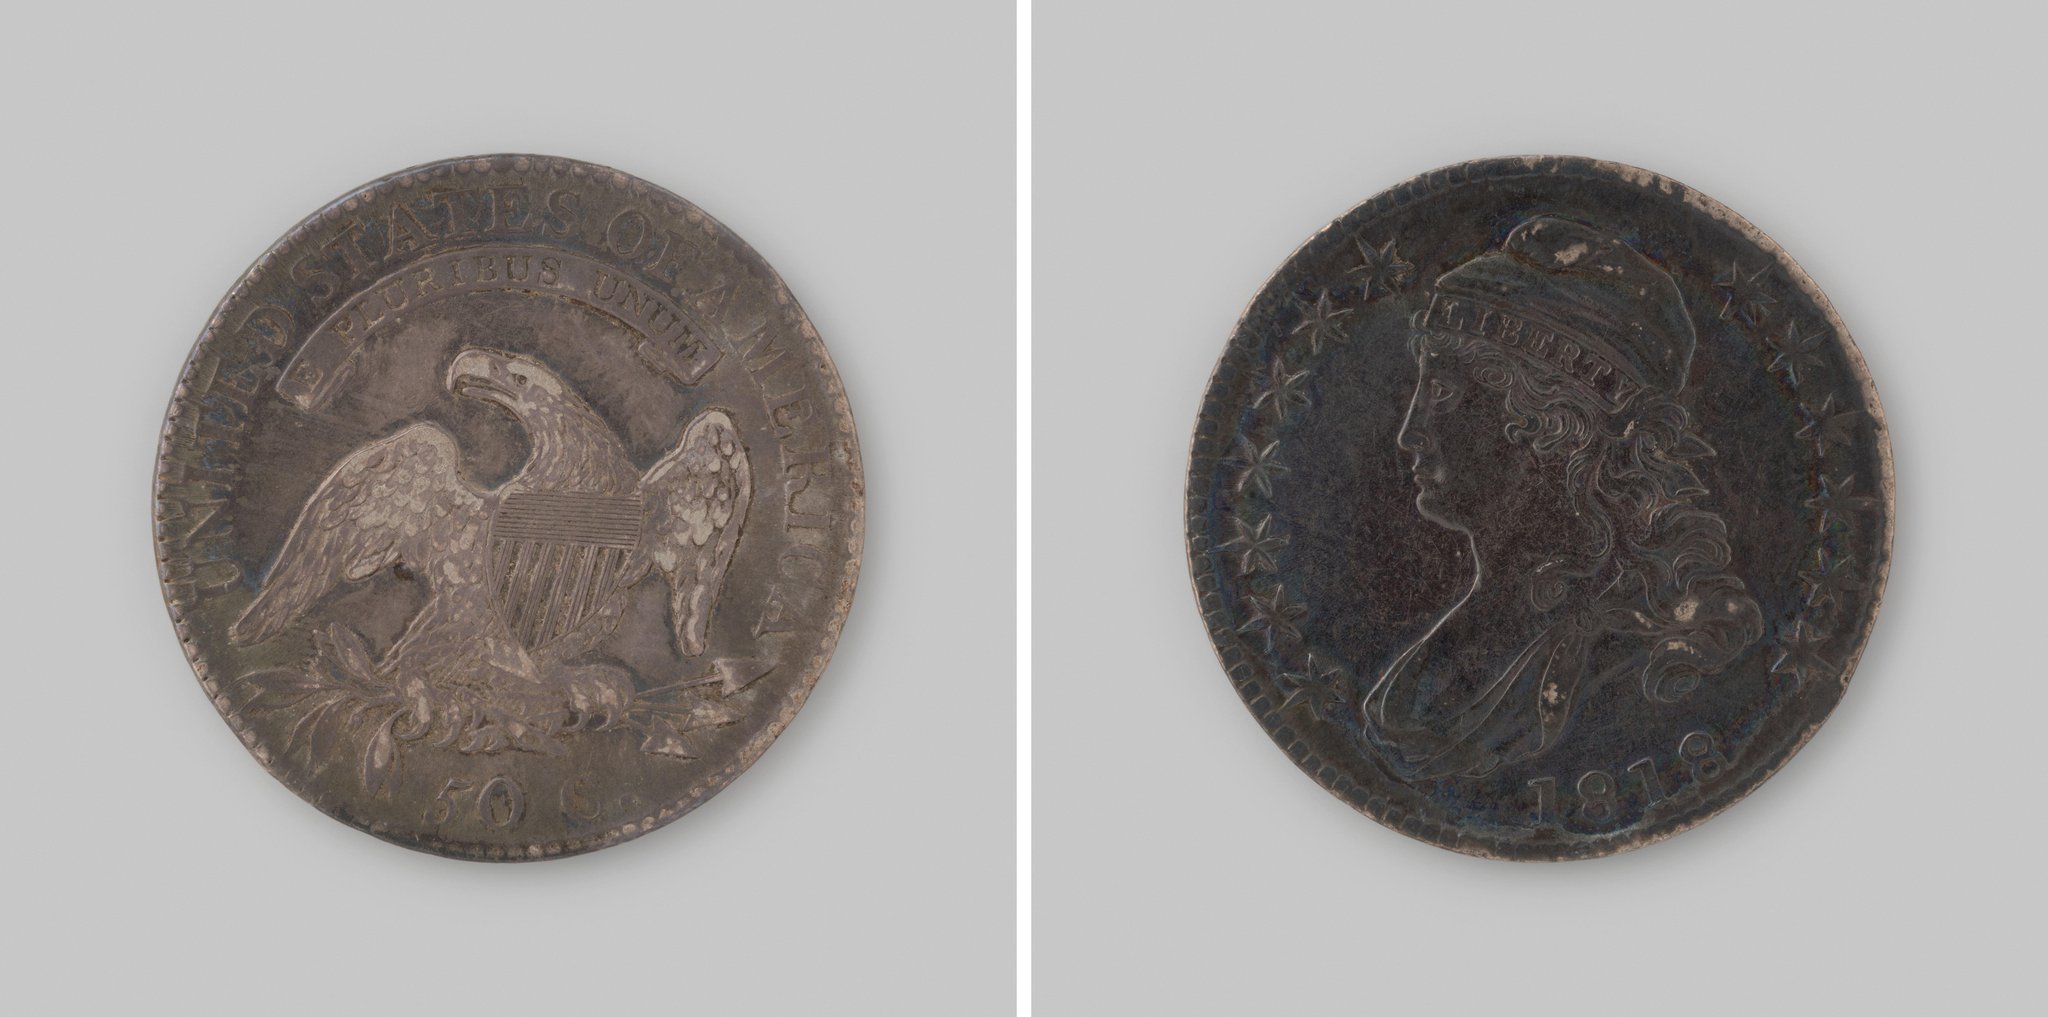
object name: coin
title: Verenigde Staten van Amerika, ½ dollar, 1818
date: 1818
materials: silver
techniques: striking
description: Zilveren munt. Voorzijde: liberty head naar links, waaromheen sterren. Jaartal onderaan. Keerzijde: adelaar met gespreide vleugels met in zijn rechterklauw tak en in zijn linker klauw pijlenbundel en op zijn borst wapenschild, omkijkend naar links. Daarboven banderol met opschrift. Waarde-aanduiding: 50 C. onderaan. Randschrift.